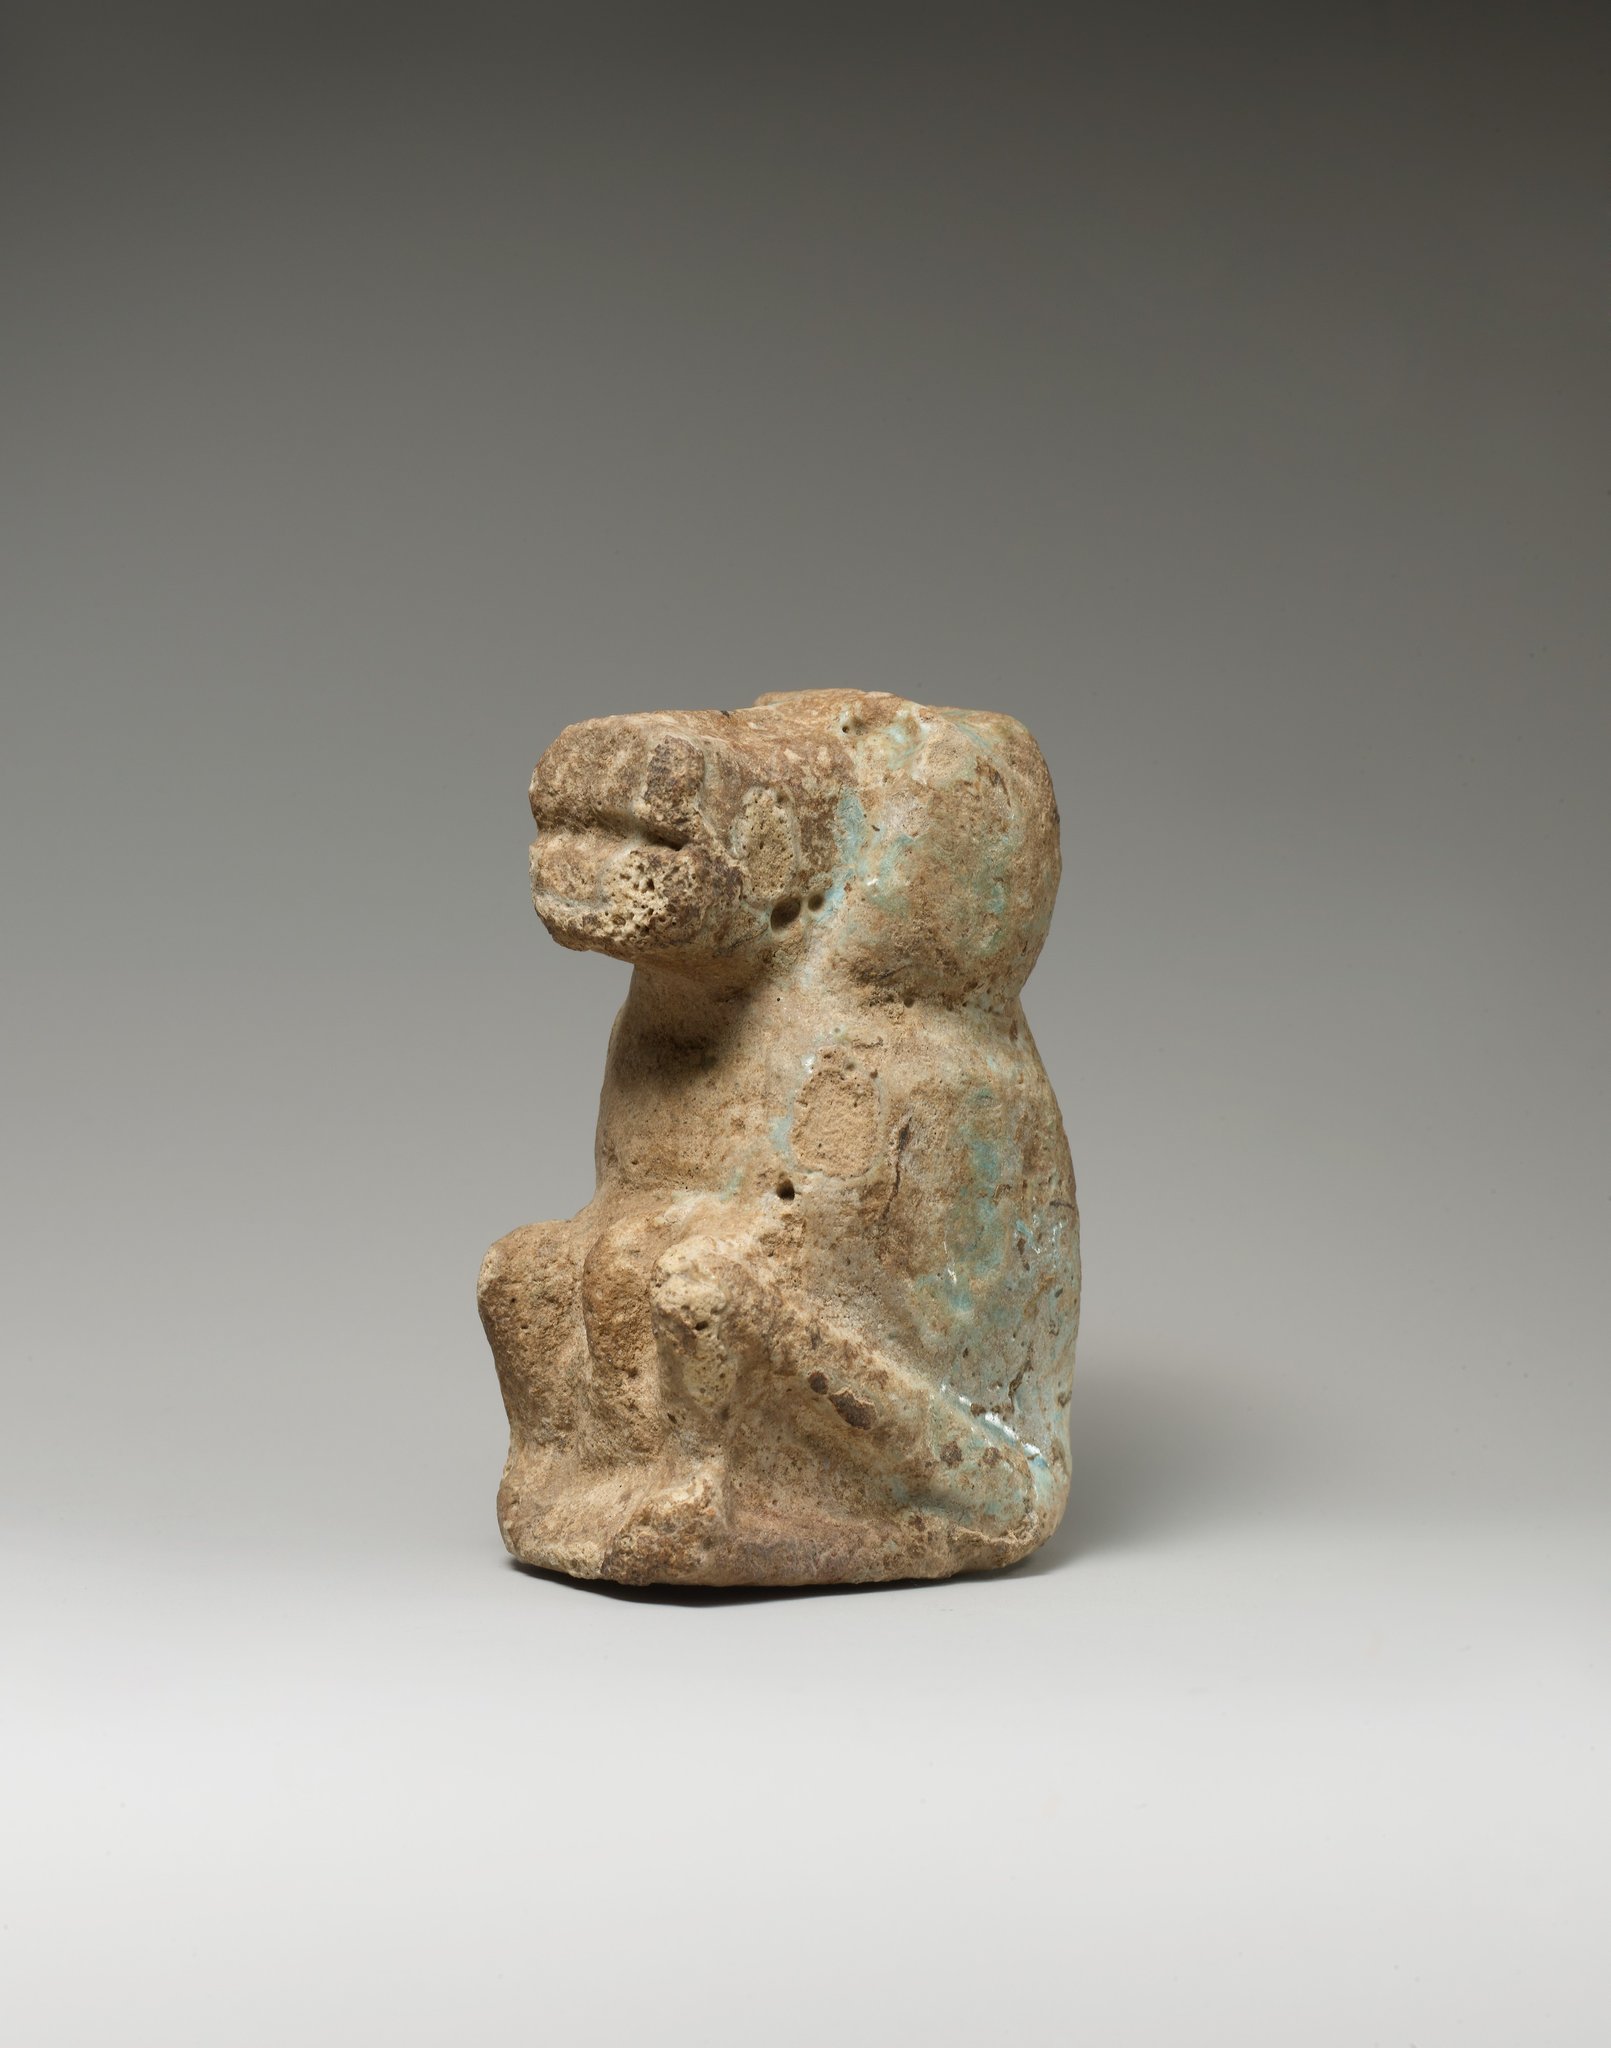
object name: figurine, baboon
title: Figurine of a baboon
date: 3100-2649 BCE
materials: faience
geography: egypt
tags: baboons